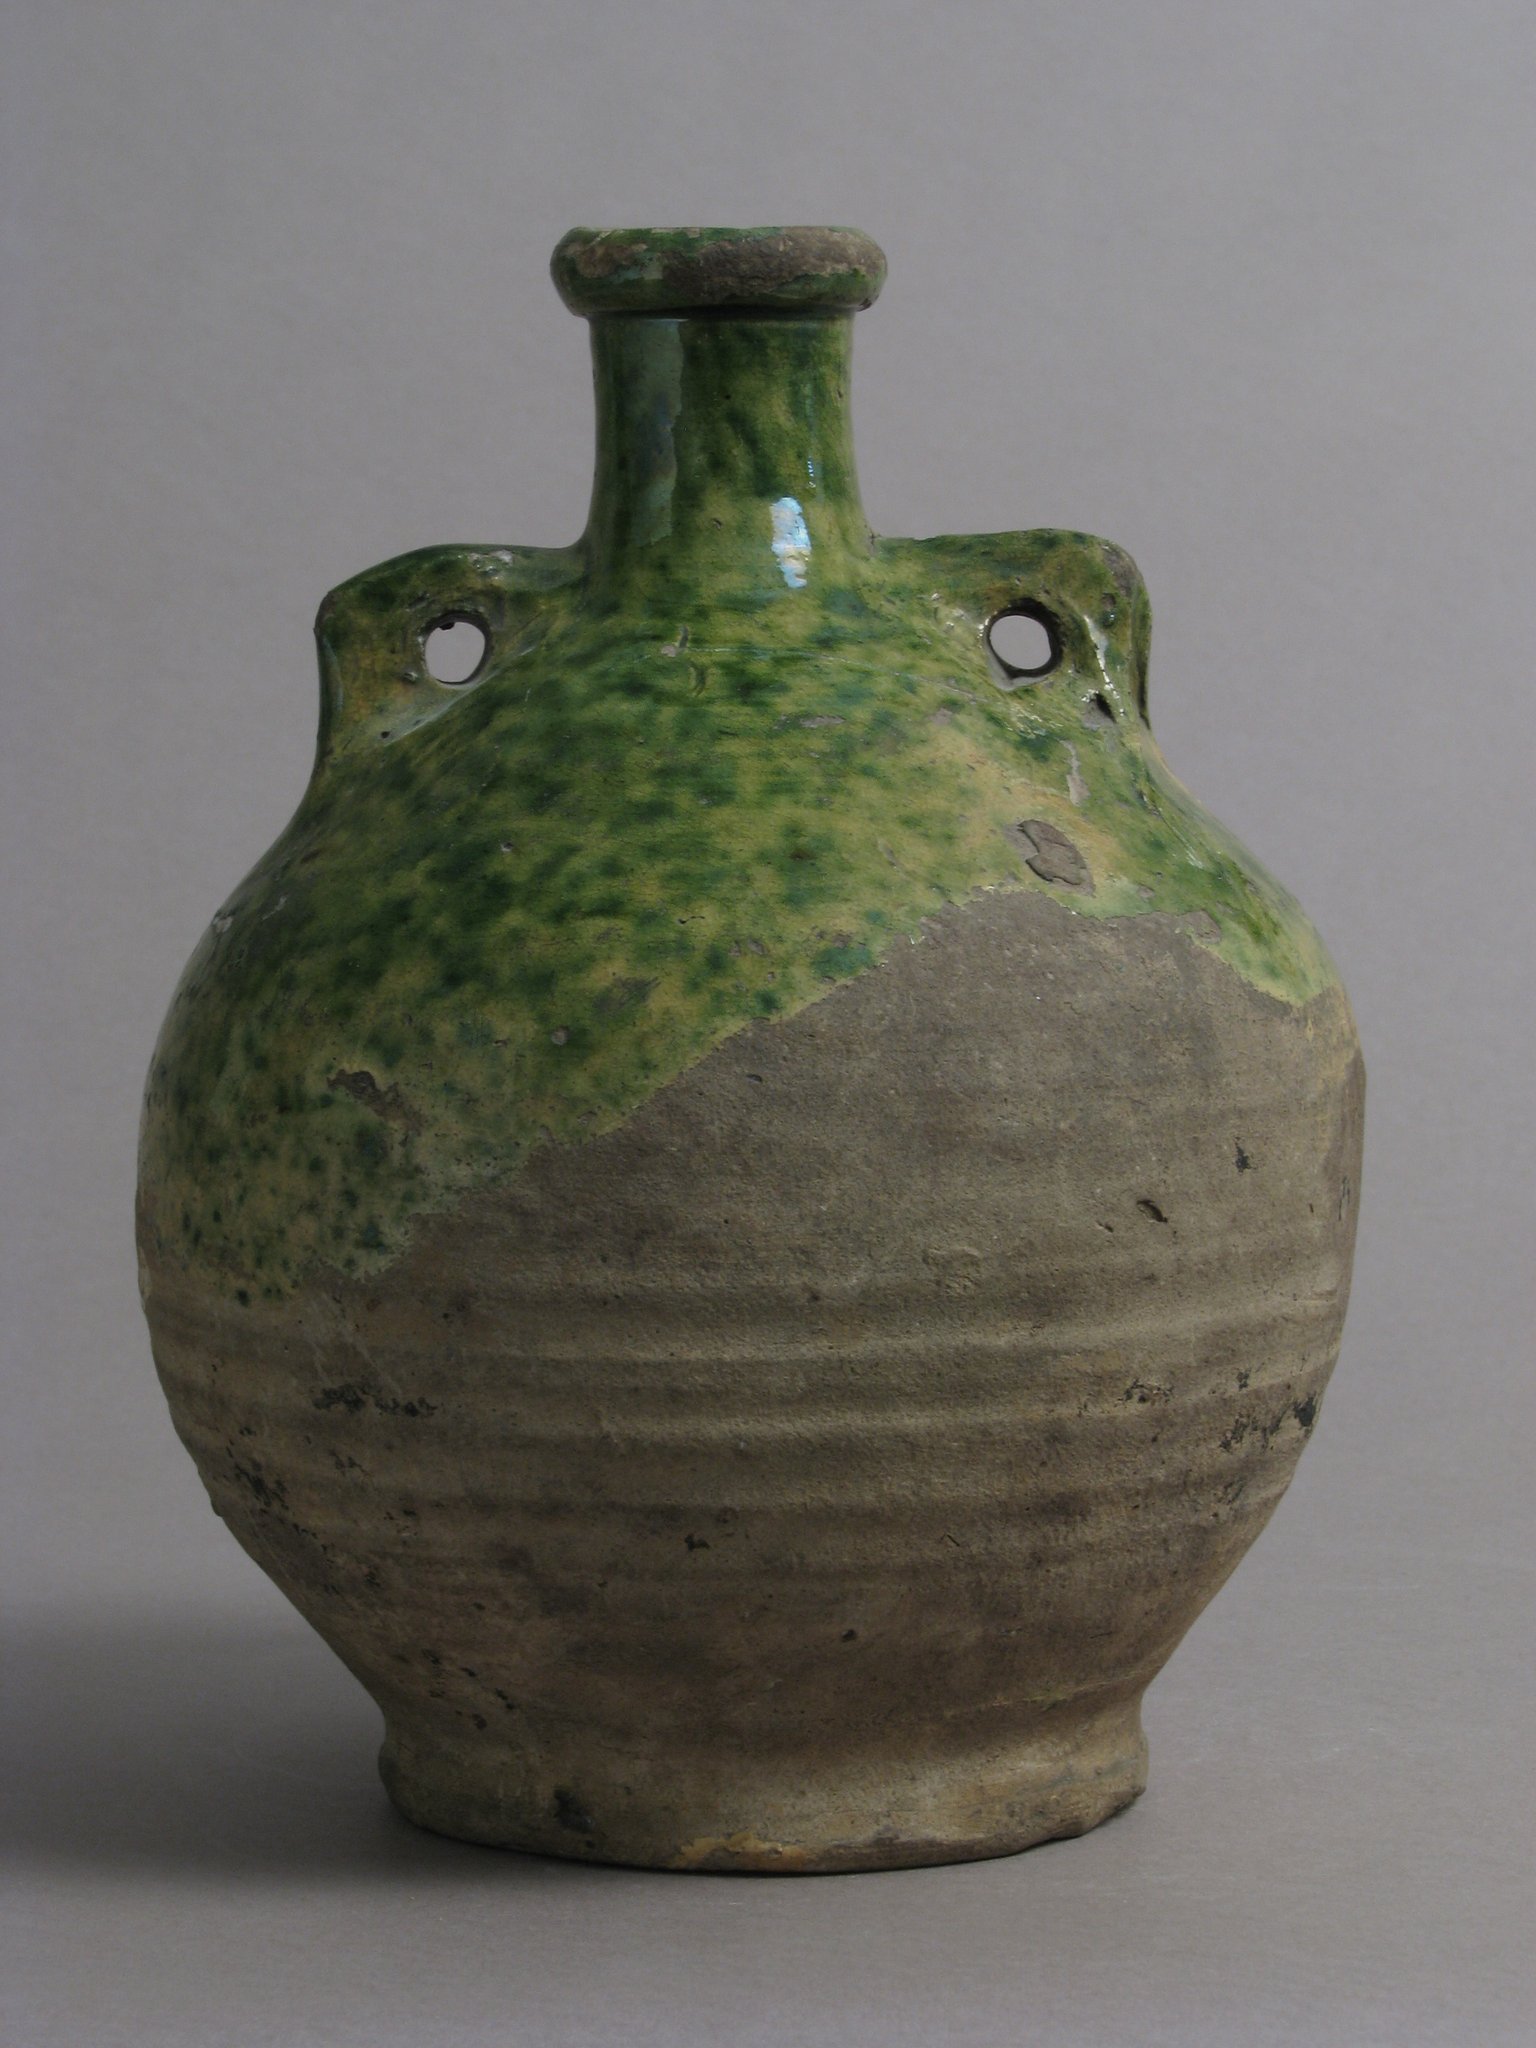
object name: flask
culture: british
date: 1400-1600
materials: earthenware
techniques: glazing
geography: england